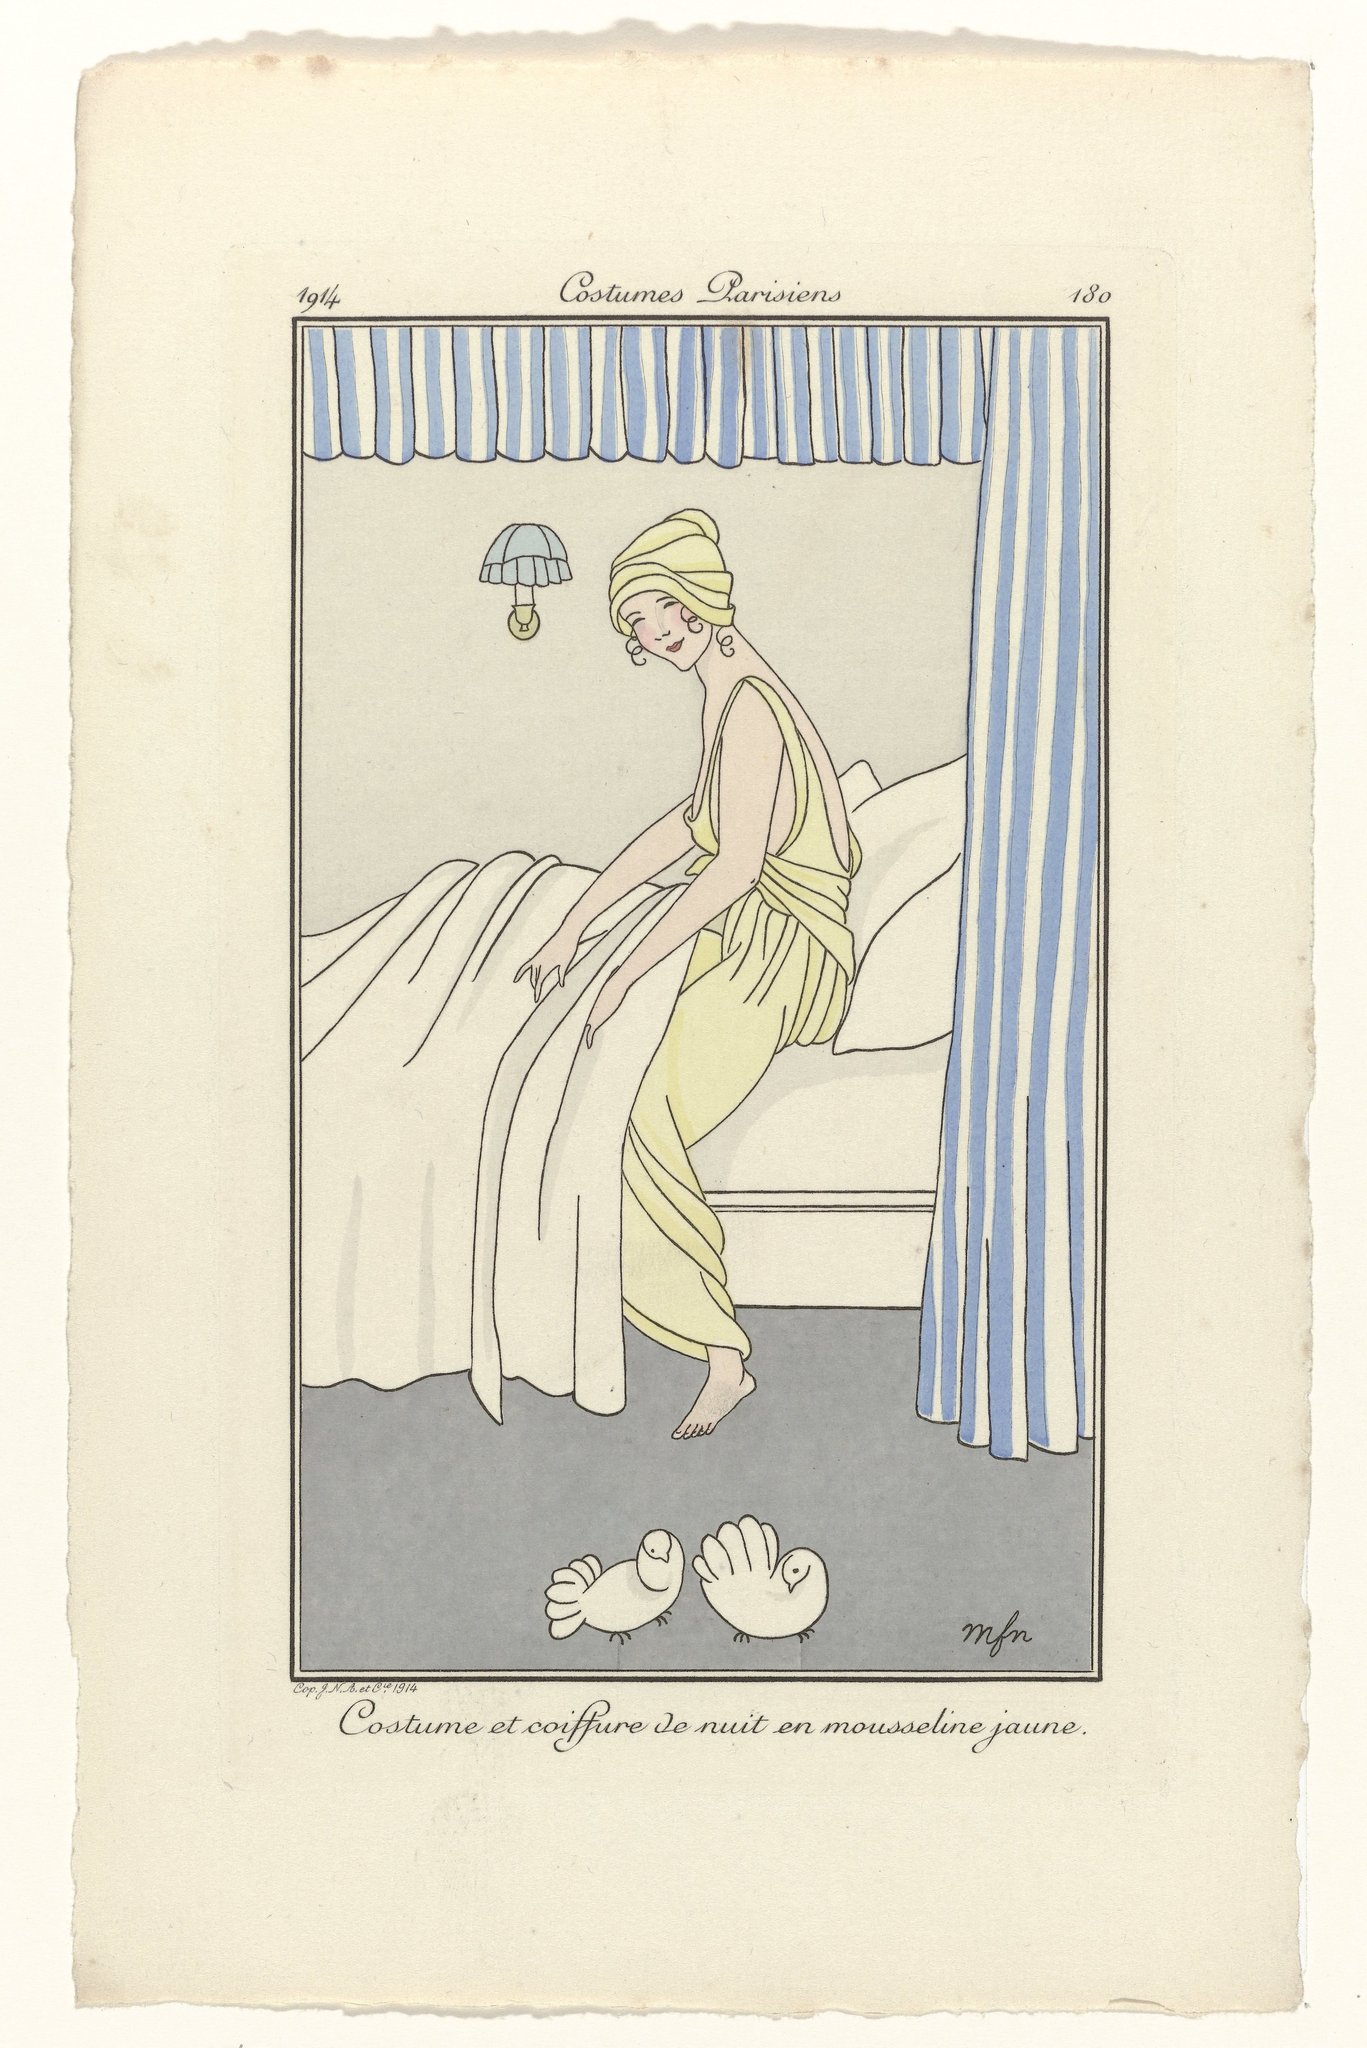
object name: fashion print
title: Journal des Dames et des Modes, Costumes Parisiens, 1914, No. 180 : Costume et coiffure de nuit (...)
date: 1914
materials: paper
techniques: engraving, hand coloring, pochoir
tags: nightwear (+ women's clothes), styles of hairdress - aa - ~ women, head-gear: cap (+ women's clothes), fashion plates, bed, going to bed, doves, pigeons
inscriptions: caption: ‘Costume et coiffure de nuit en mousseline jaune.’, inscription: ‘Cop. J. N. A. et Cie 1914’, title: ‘Costumes Parisiens’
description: Nachtjapon en slaapmuts van gele mousseline. Prent uit het modetijdschrift Journal des Dames et des Modes (1912-1914).